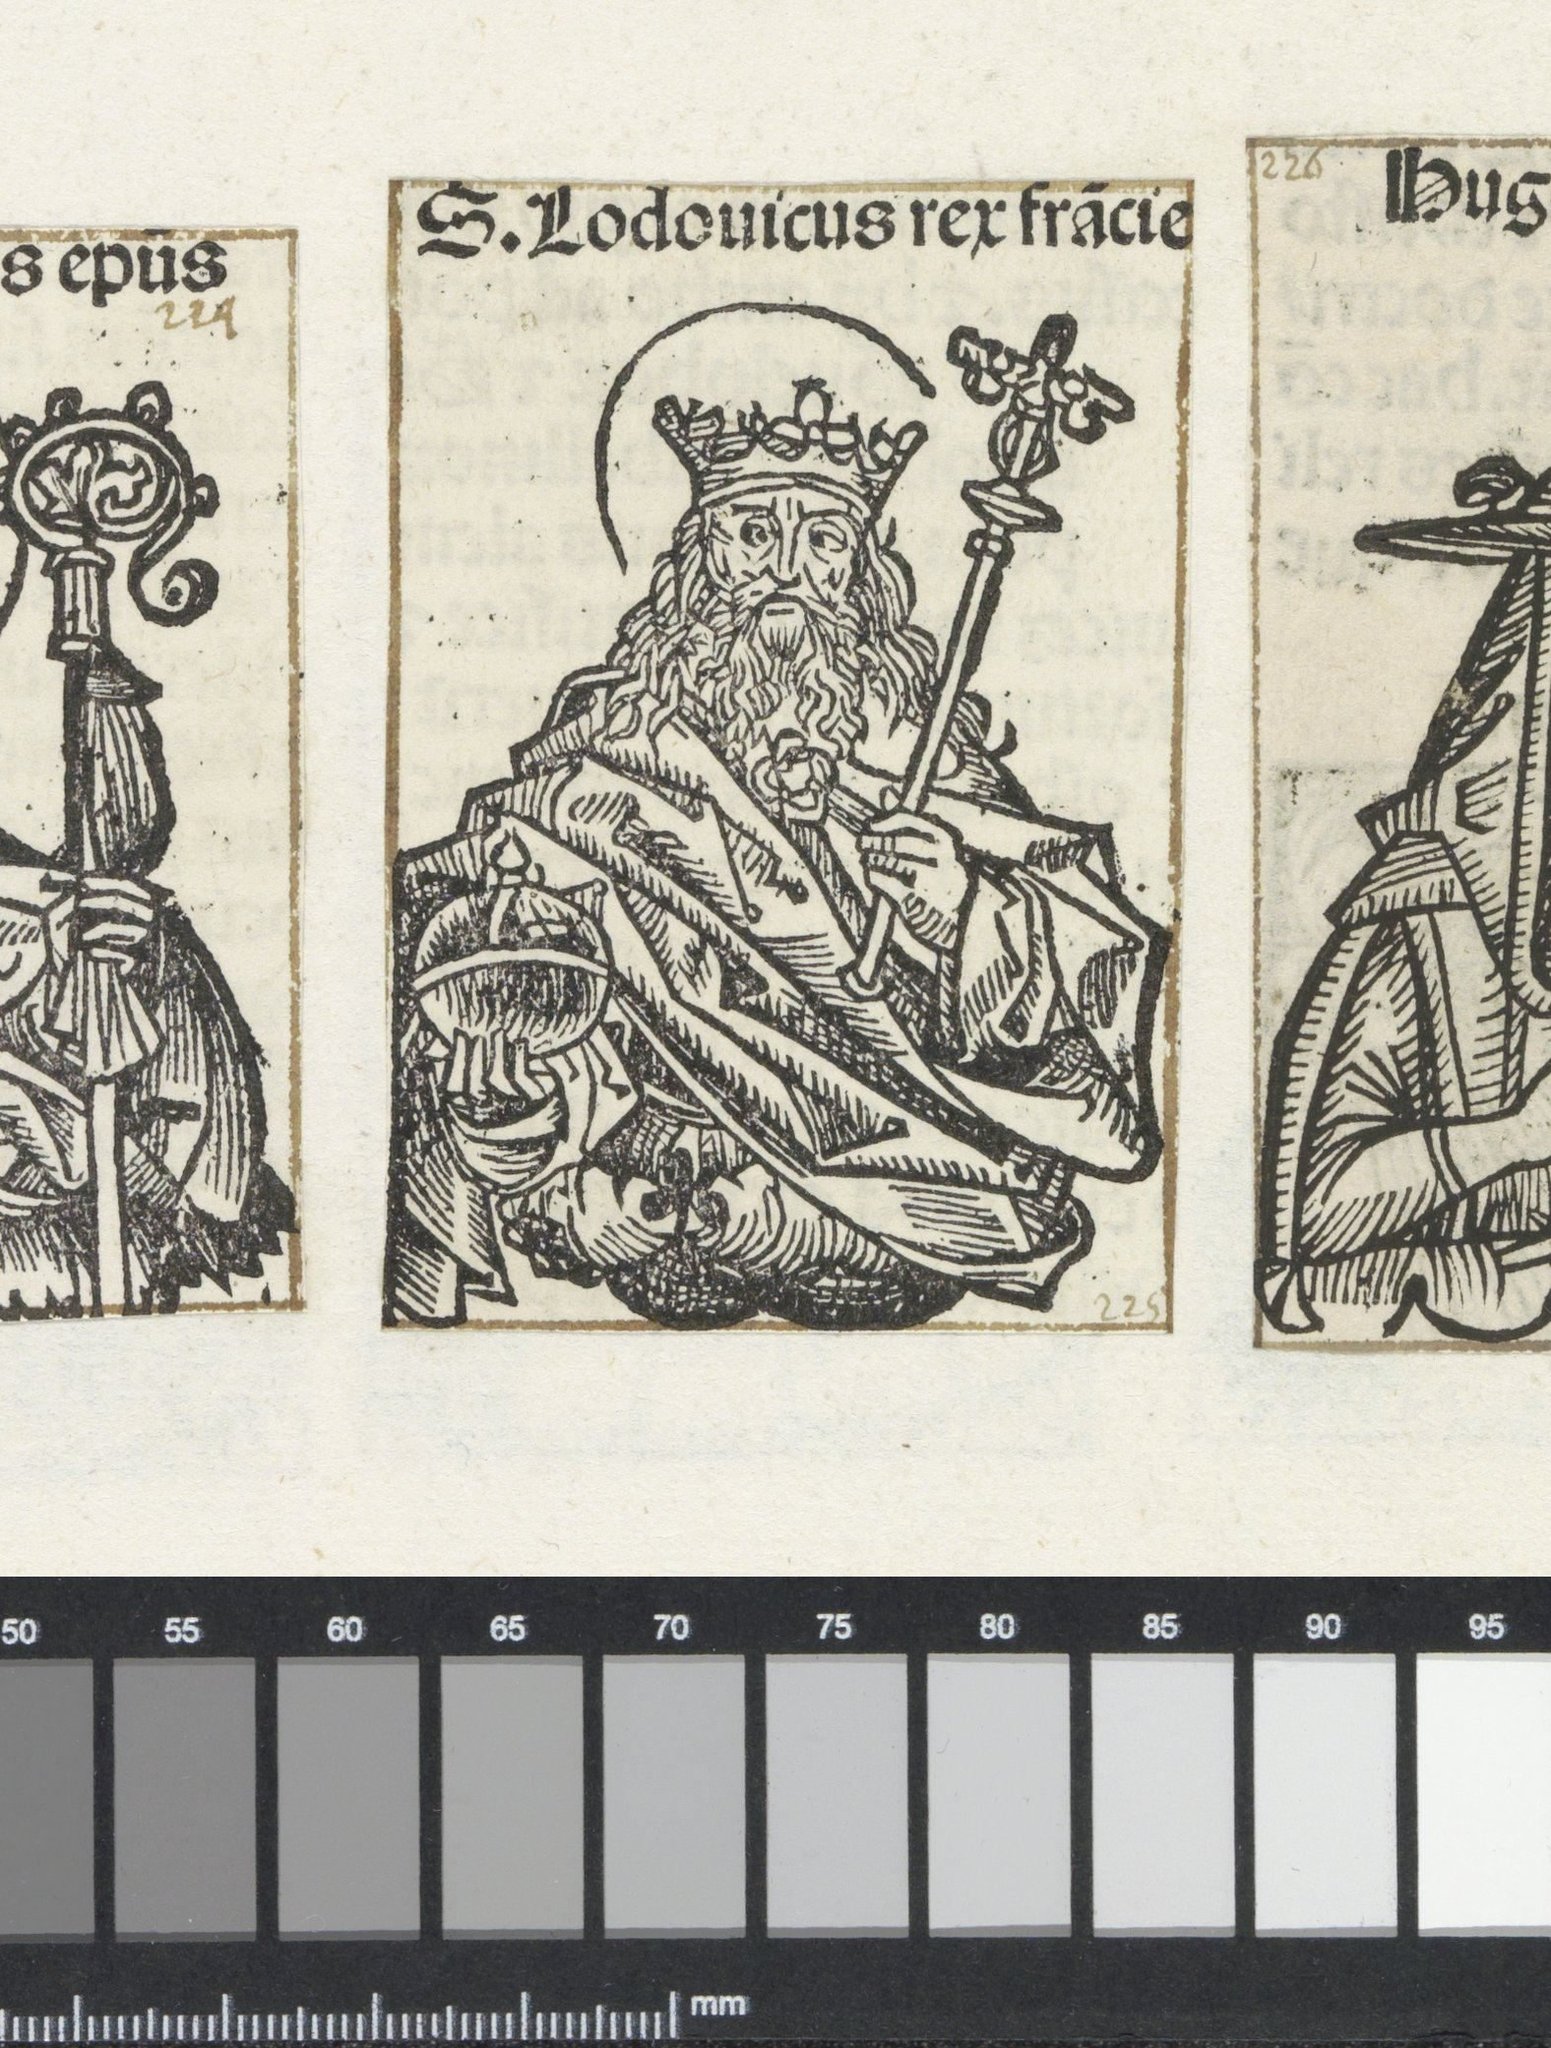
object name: book illustration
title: S. Lodovicus rex fra[n]cie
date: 1493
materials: paper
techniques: letterpress printing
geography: nuremberg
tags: saints, king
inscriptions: inscription: ‘225’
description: Een bloemkelk met een koning. Hij heeft een scepter en een rijksappel in de handen. Om zijn hoofd een nimbus. De tekst identificeert de man als Lodewijk IX van Frankrijk, bijgenaamd de Heilige. De prent maakt deel uit van een album.